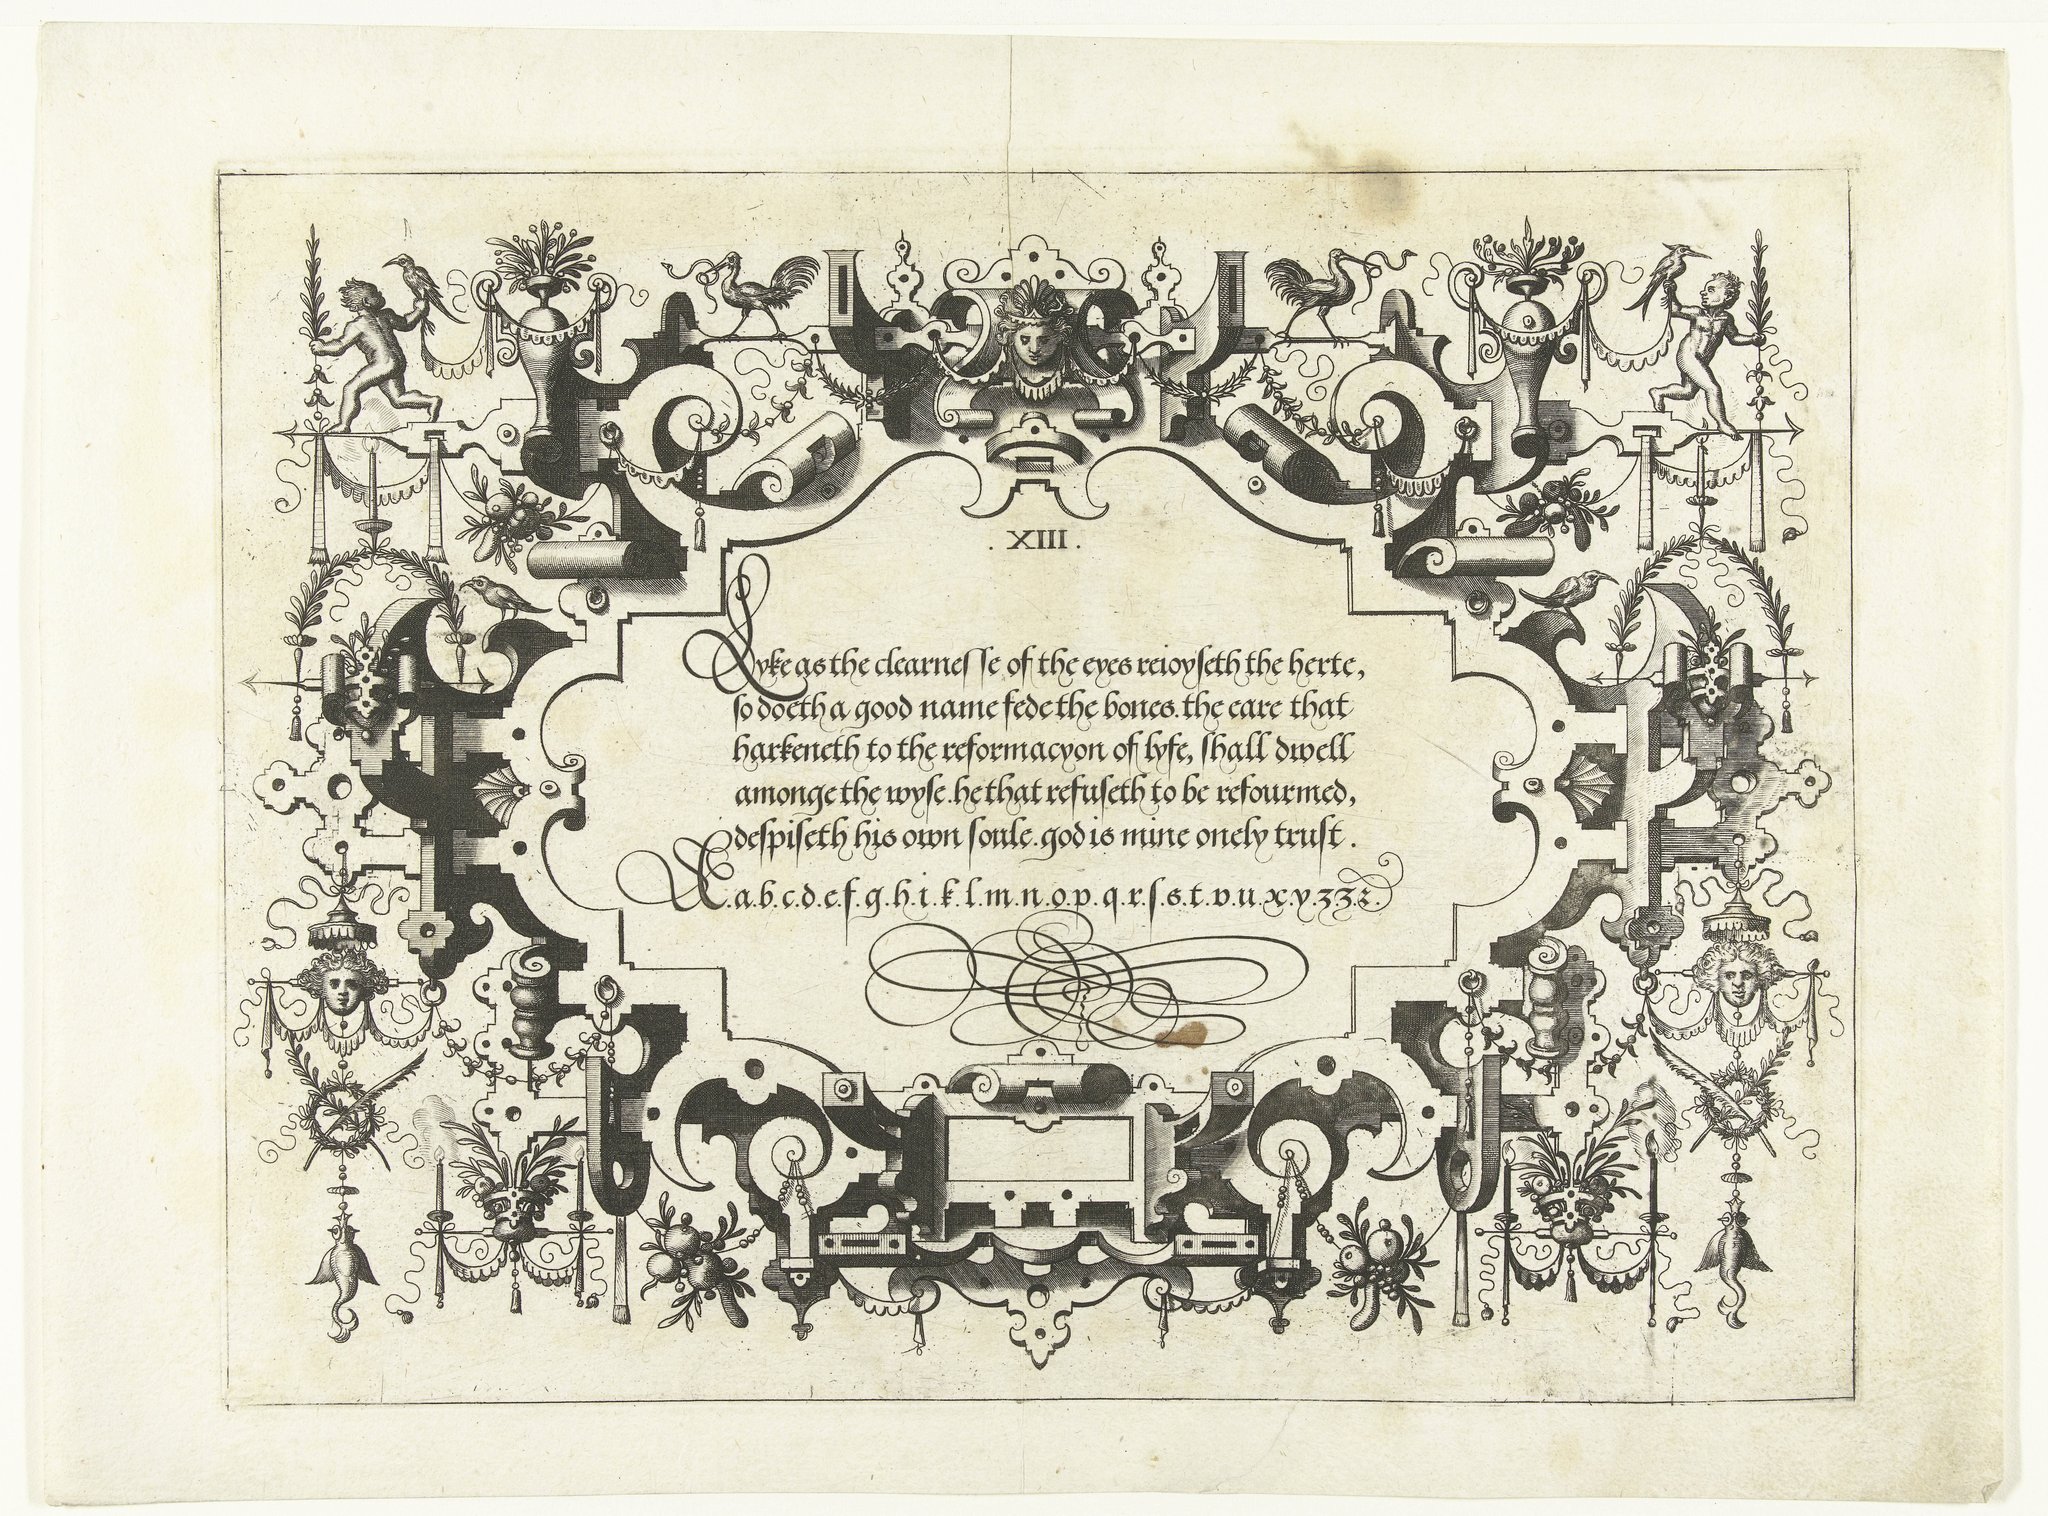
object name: print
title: Cartouche met kalligrafie, links- en rechtsboven een kind met vogel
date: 1569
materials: paper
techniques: engraving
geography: netherlands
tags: canopy, baldachin, scrollwork, strapwork ~ ornament, birds, ornament ~ cartouche, calligraphy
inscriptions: inscription: ‘15a 5-4-'77’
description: Blad XIII. Cartouche met tekst Lyke as the claernesse of the eyes.... Aan beide zijkanten van de cartouche hangt een baldakijn met onderaan een vis. Uit serie van 21 genummerde cartouches met kalligrafie in een omlijsting van rol- en beslagwerk met grotesken, guirlandes en mascarons.